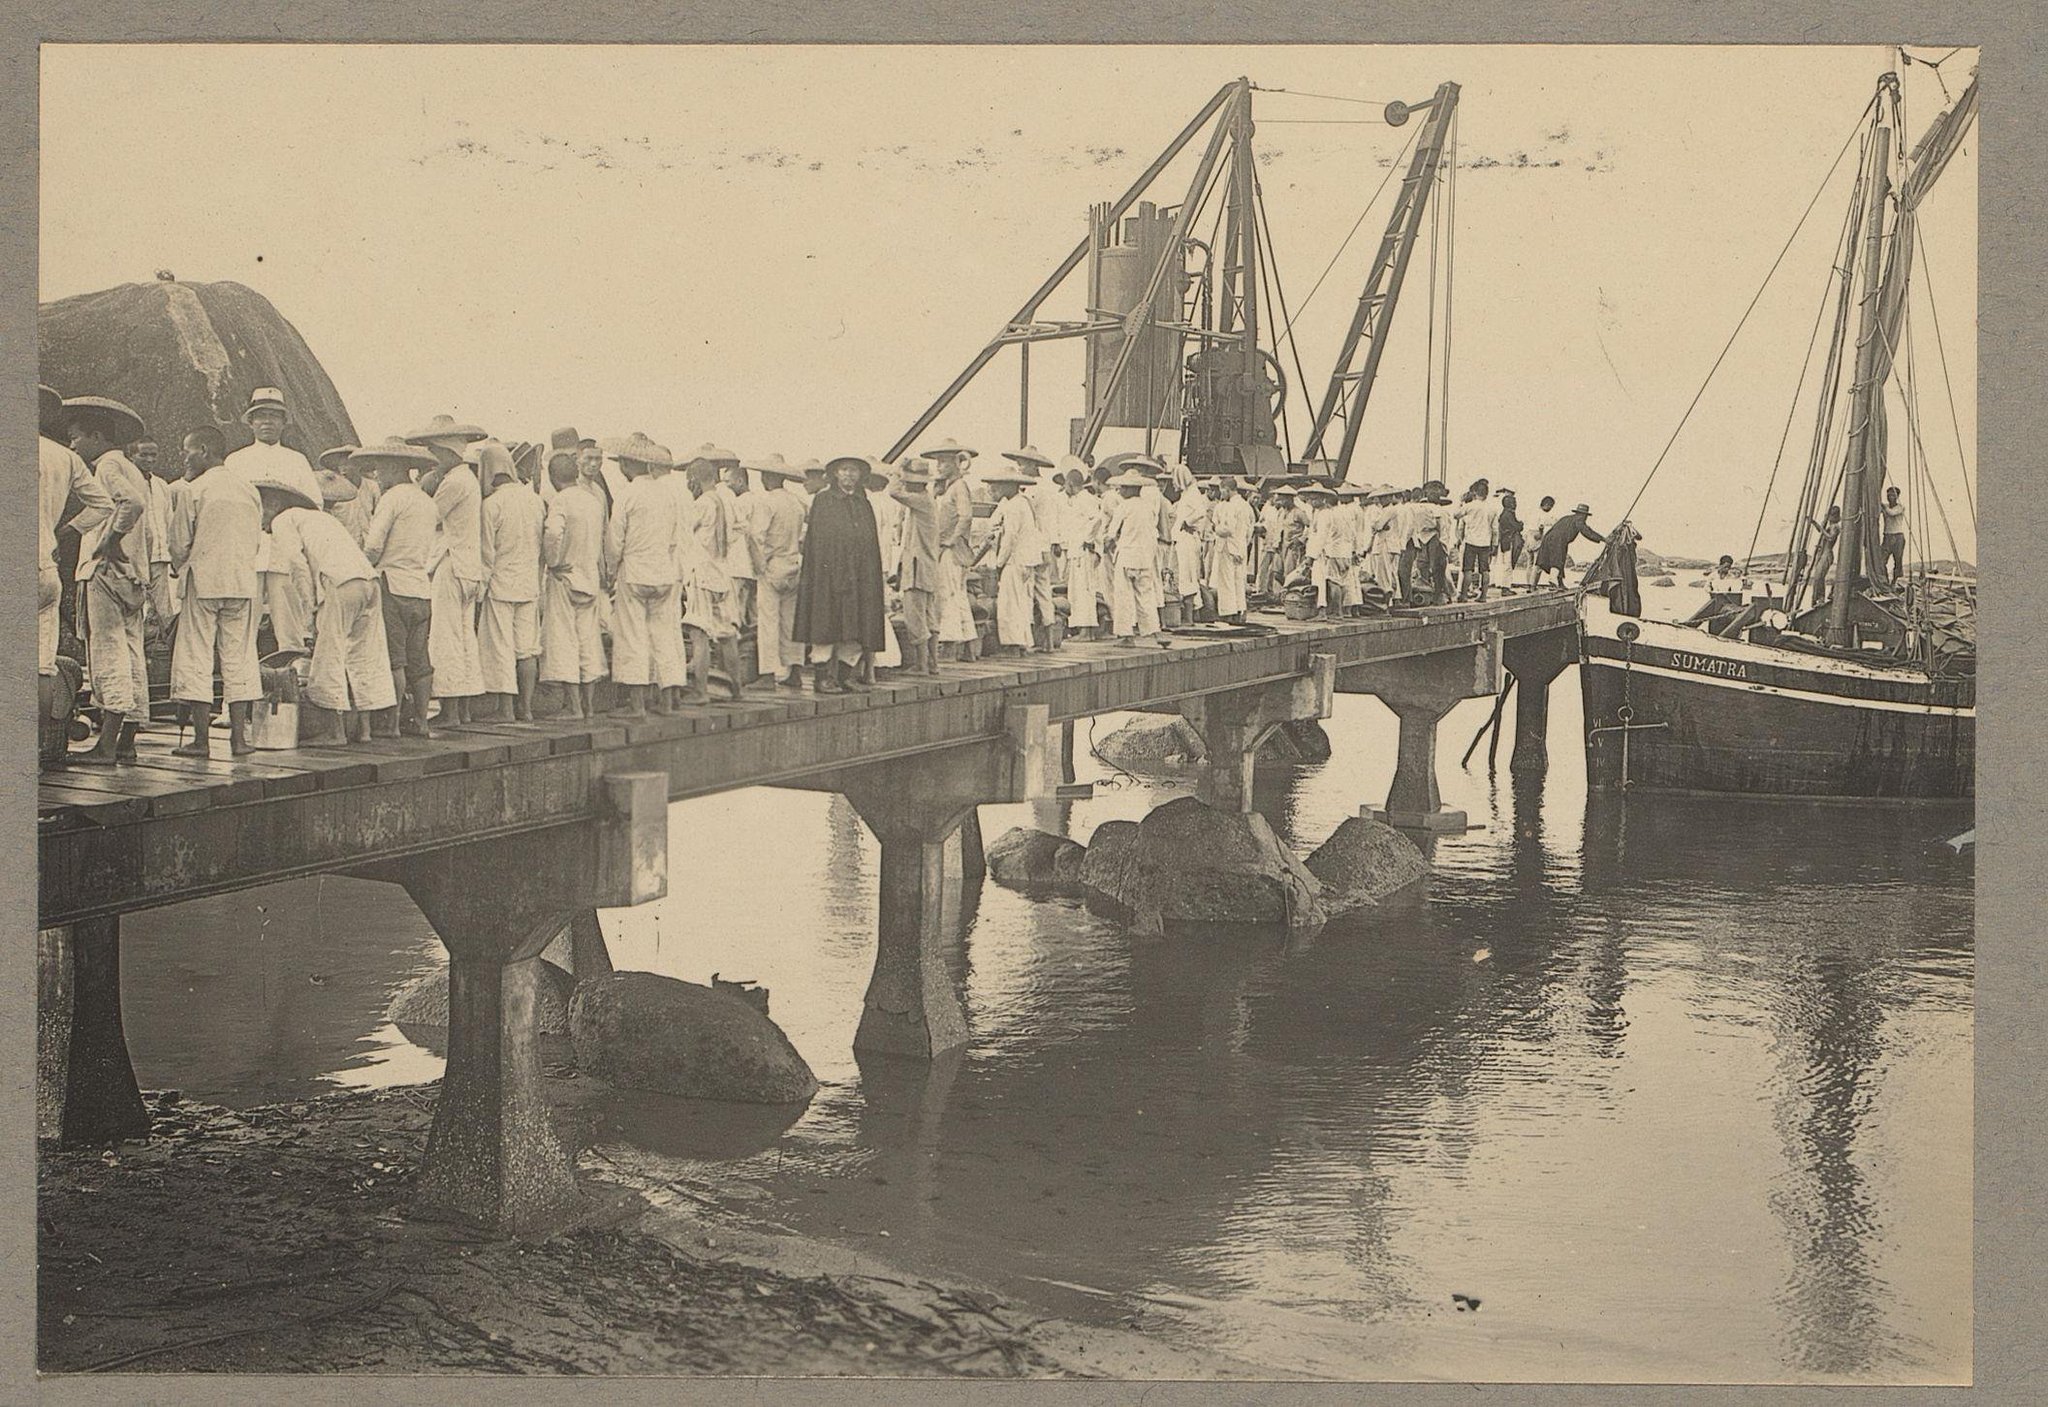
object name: photograph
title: Landing van Chineesche nieuwelingen te Mantoeng (Blinjoe)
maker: Anonymous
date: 1914-1919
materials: photographic support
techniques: gelatin silver print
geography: bangka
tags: robert julius boers, colonial system, mining, working class, labourers, pier, quay, wharf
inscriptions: inscription: ‘Landing van Chineesche nieuwelingen te Mantoeng (Blinjoe)’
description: Aankomst van een nieuwe groep van Chinese contractarbeiders op een steiger in Mantoeng bij Blinjoe. Onderdeel van het fotoalbum aangeboden aan Robert Julius Boers bij zijn vertrek naar Nederland in 1919 door het personeel van de Banka-tinwinning.